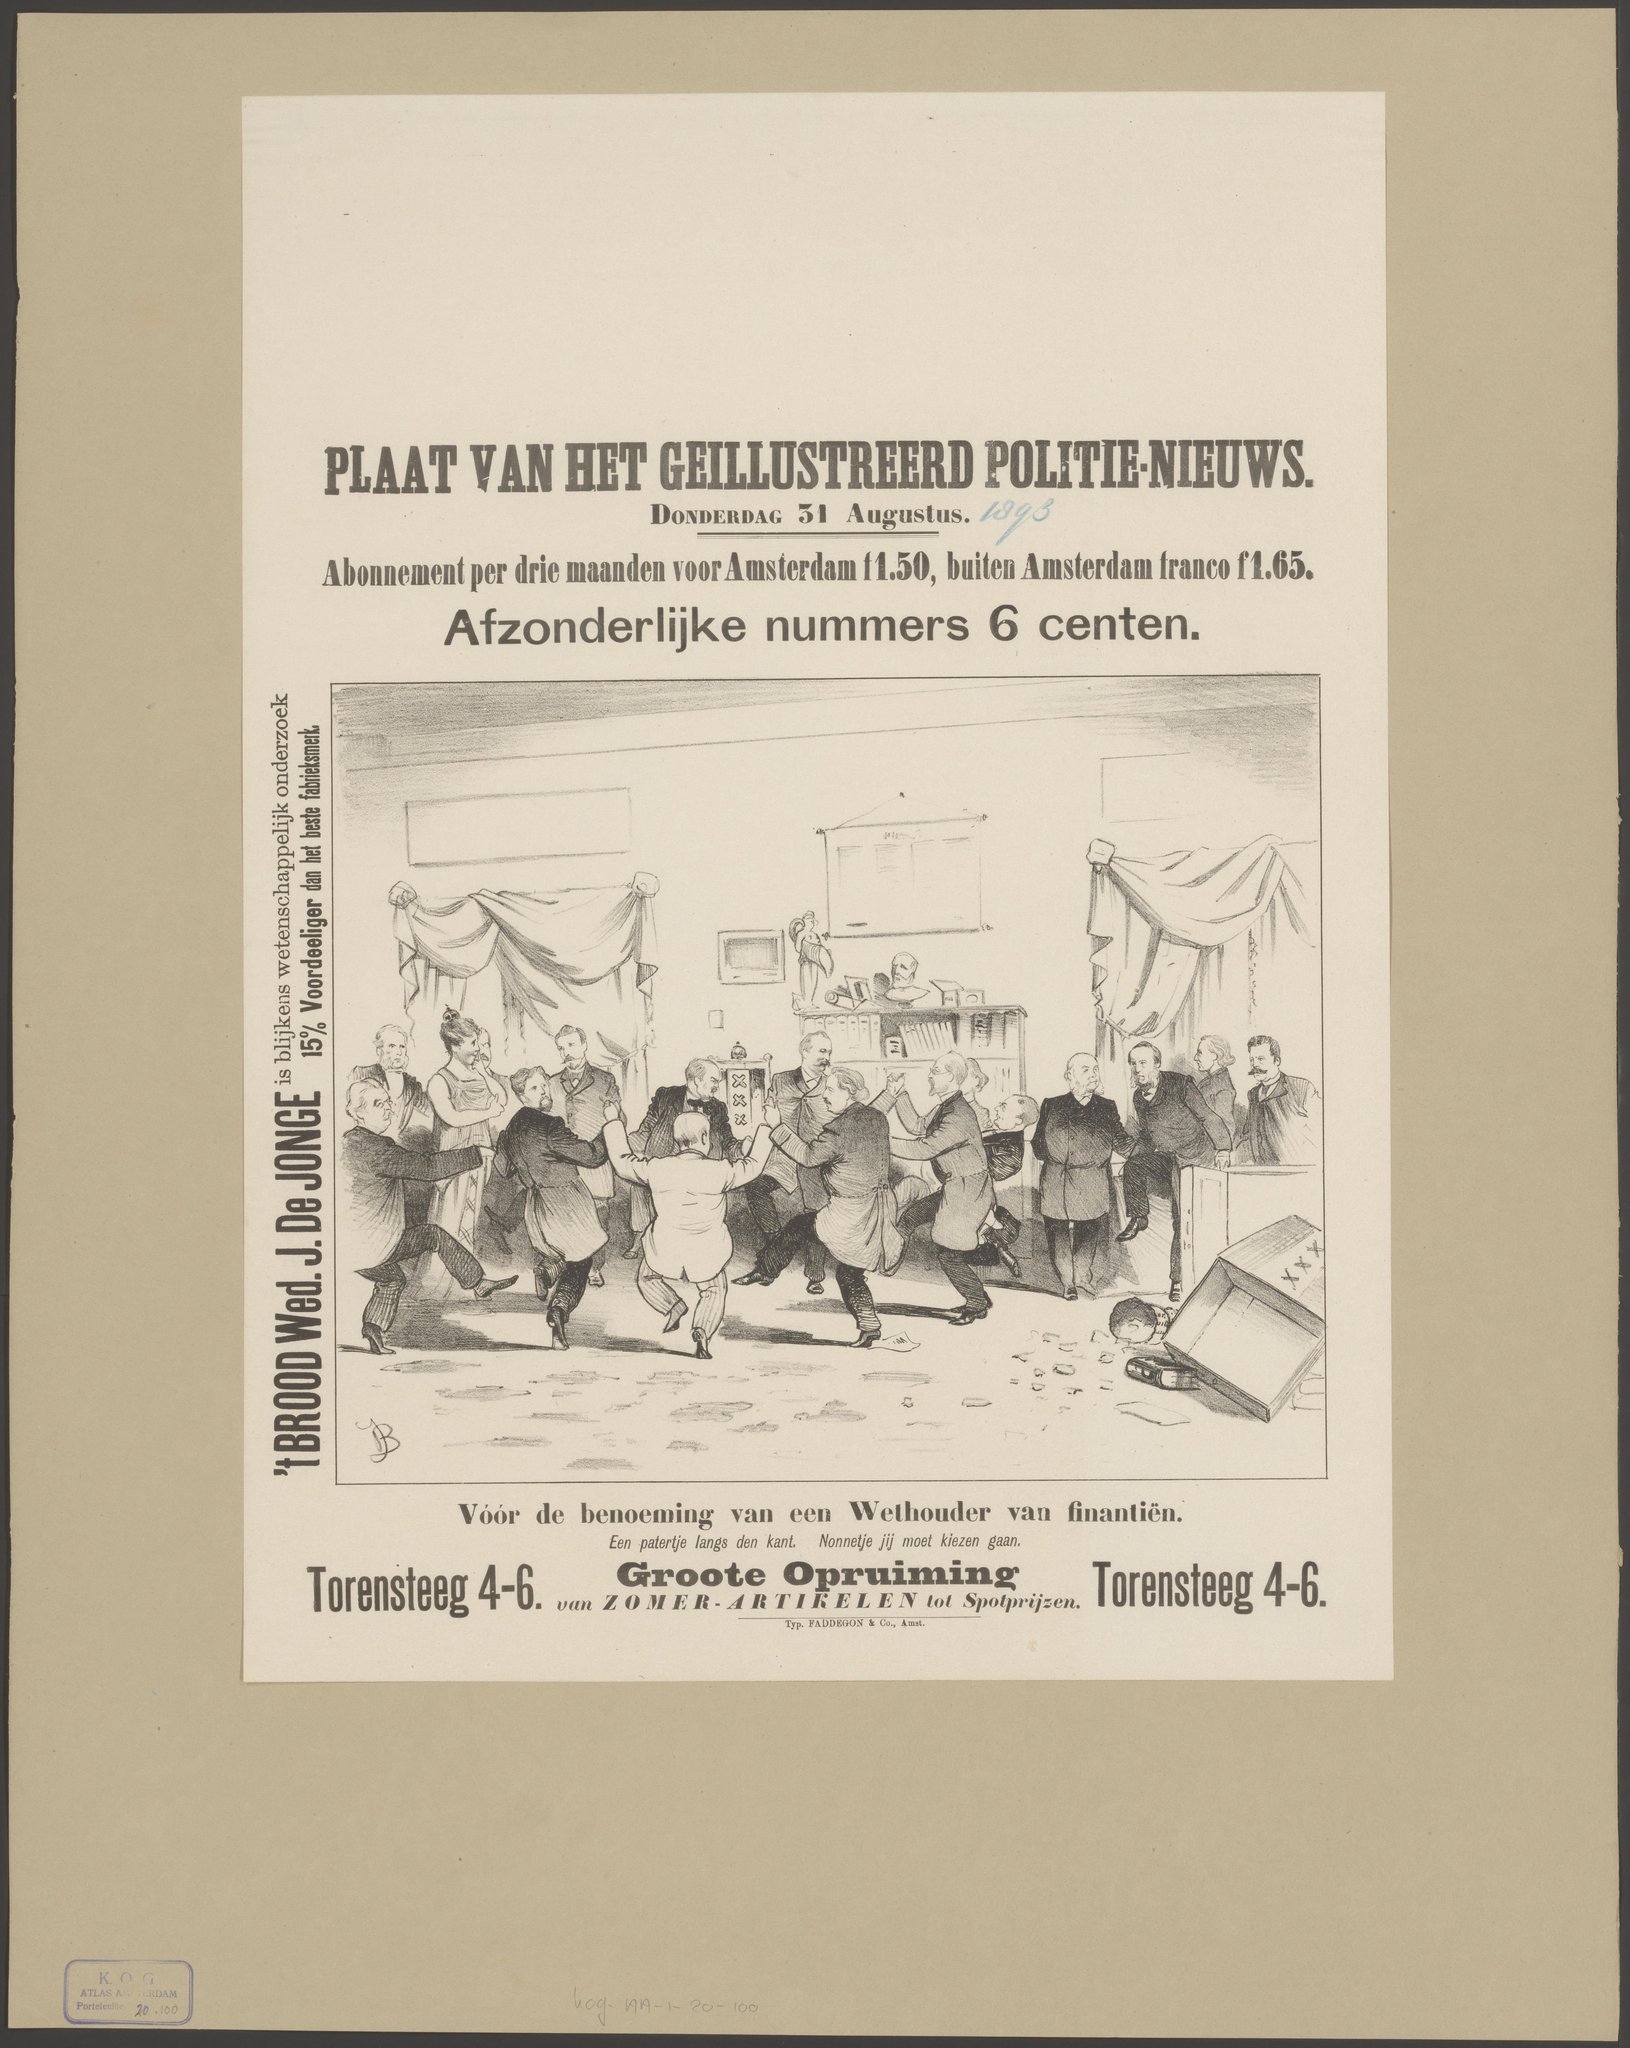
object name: cartoon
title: Mannen dansen hand in hand rond de Amsterdamse stedenmaagd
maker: johan braakensiek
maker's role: draughtsman, print maker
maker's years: 1858-1940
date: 1893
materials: paper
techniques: letterpress printing, lithograph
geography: amsterdam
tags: personification of a city, town-patron(ess), group dancing around someone or something (folk dancing), political caricatures and satires, amsterdam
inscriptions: collector's mark: Lugt 1641b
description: Gepubliceerd als bijvoegsel van 'Geïllustreerd Politie-Nieuws', 31 augustus 1893.